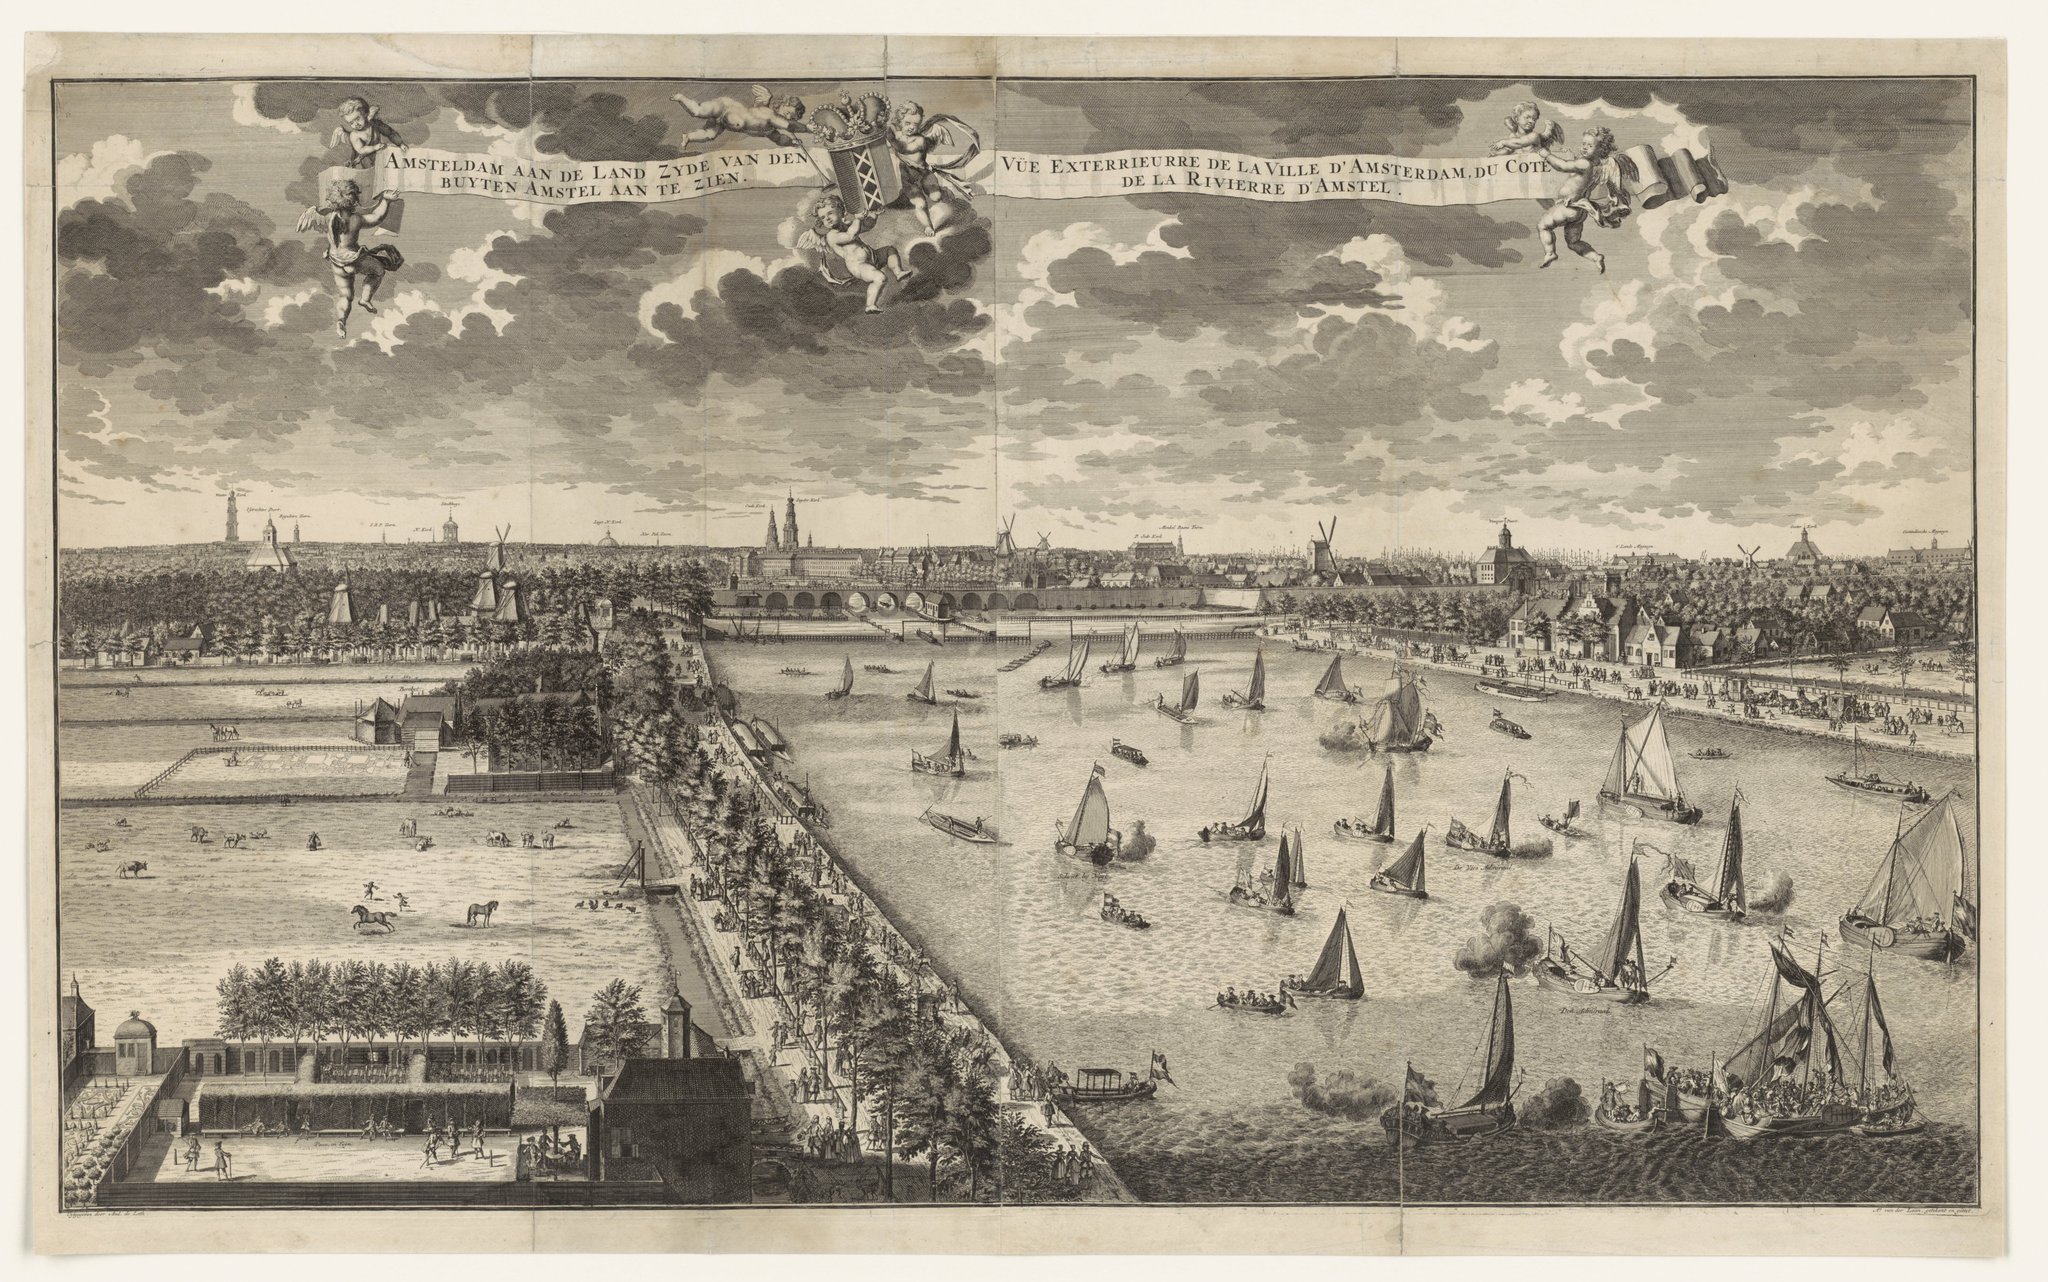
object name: print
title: "Amsteldam aan de Land zijde van den Buyten Amstel aan te zien"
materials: paper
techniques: etching